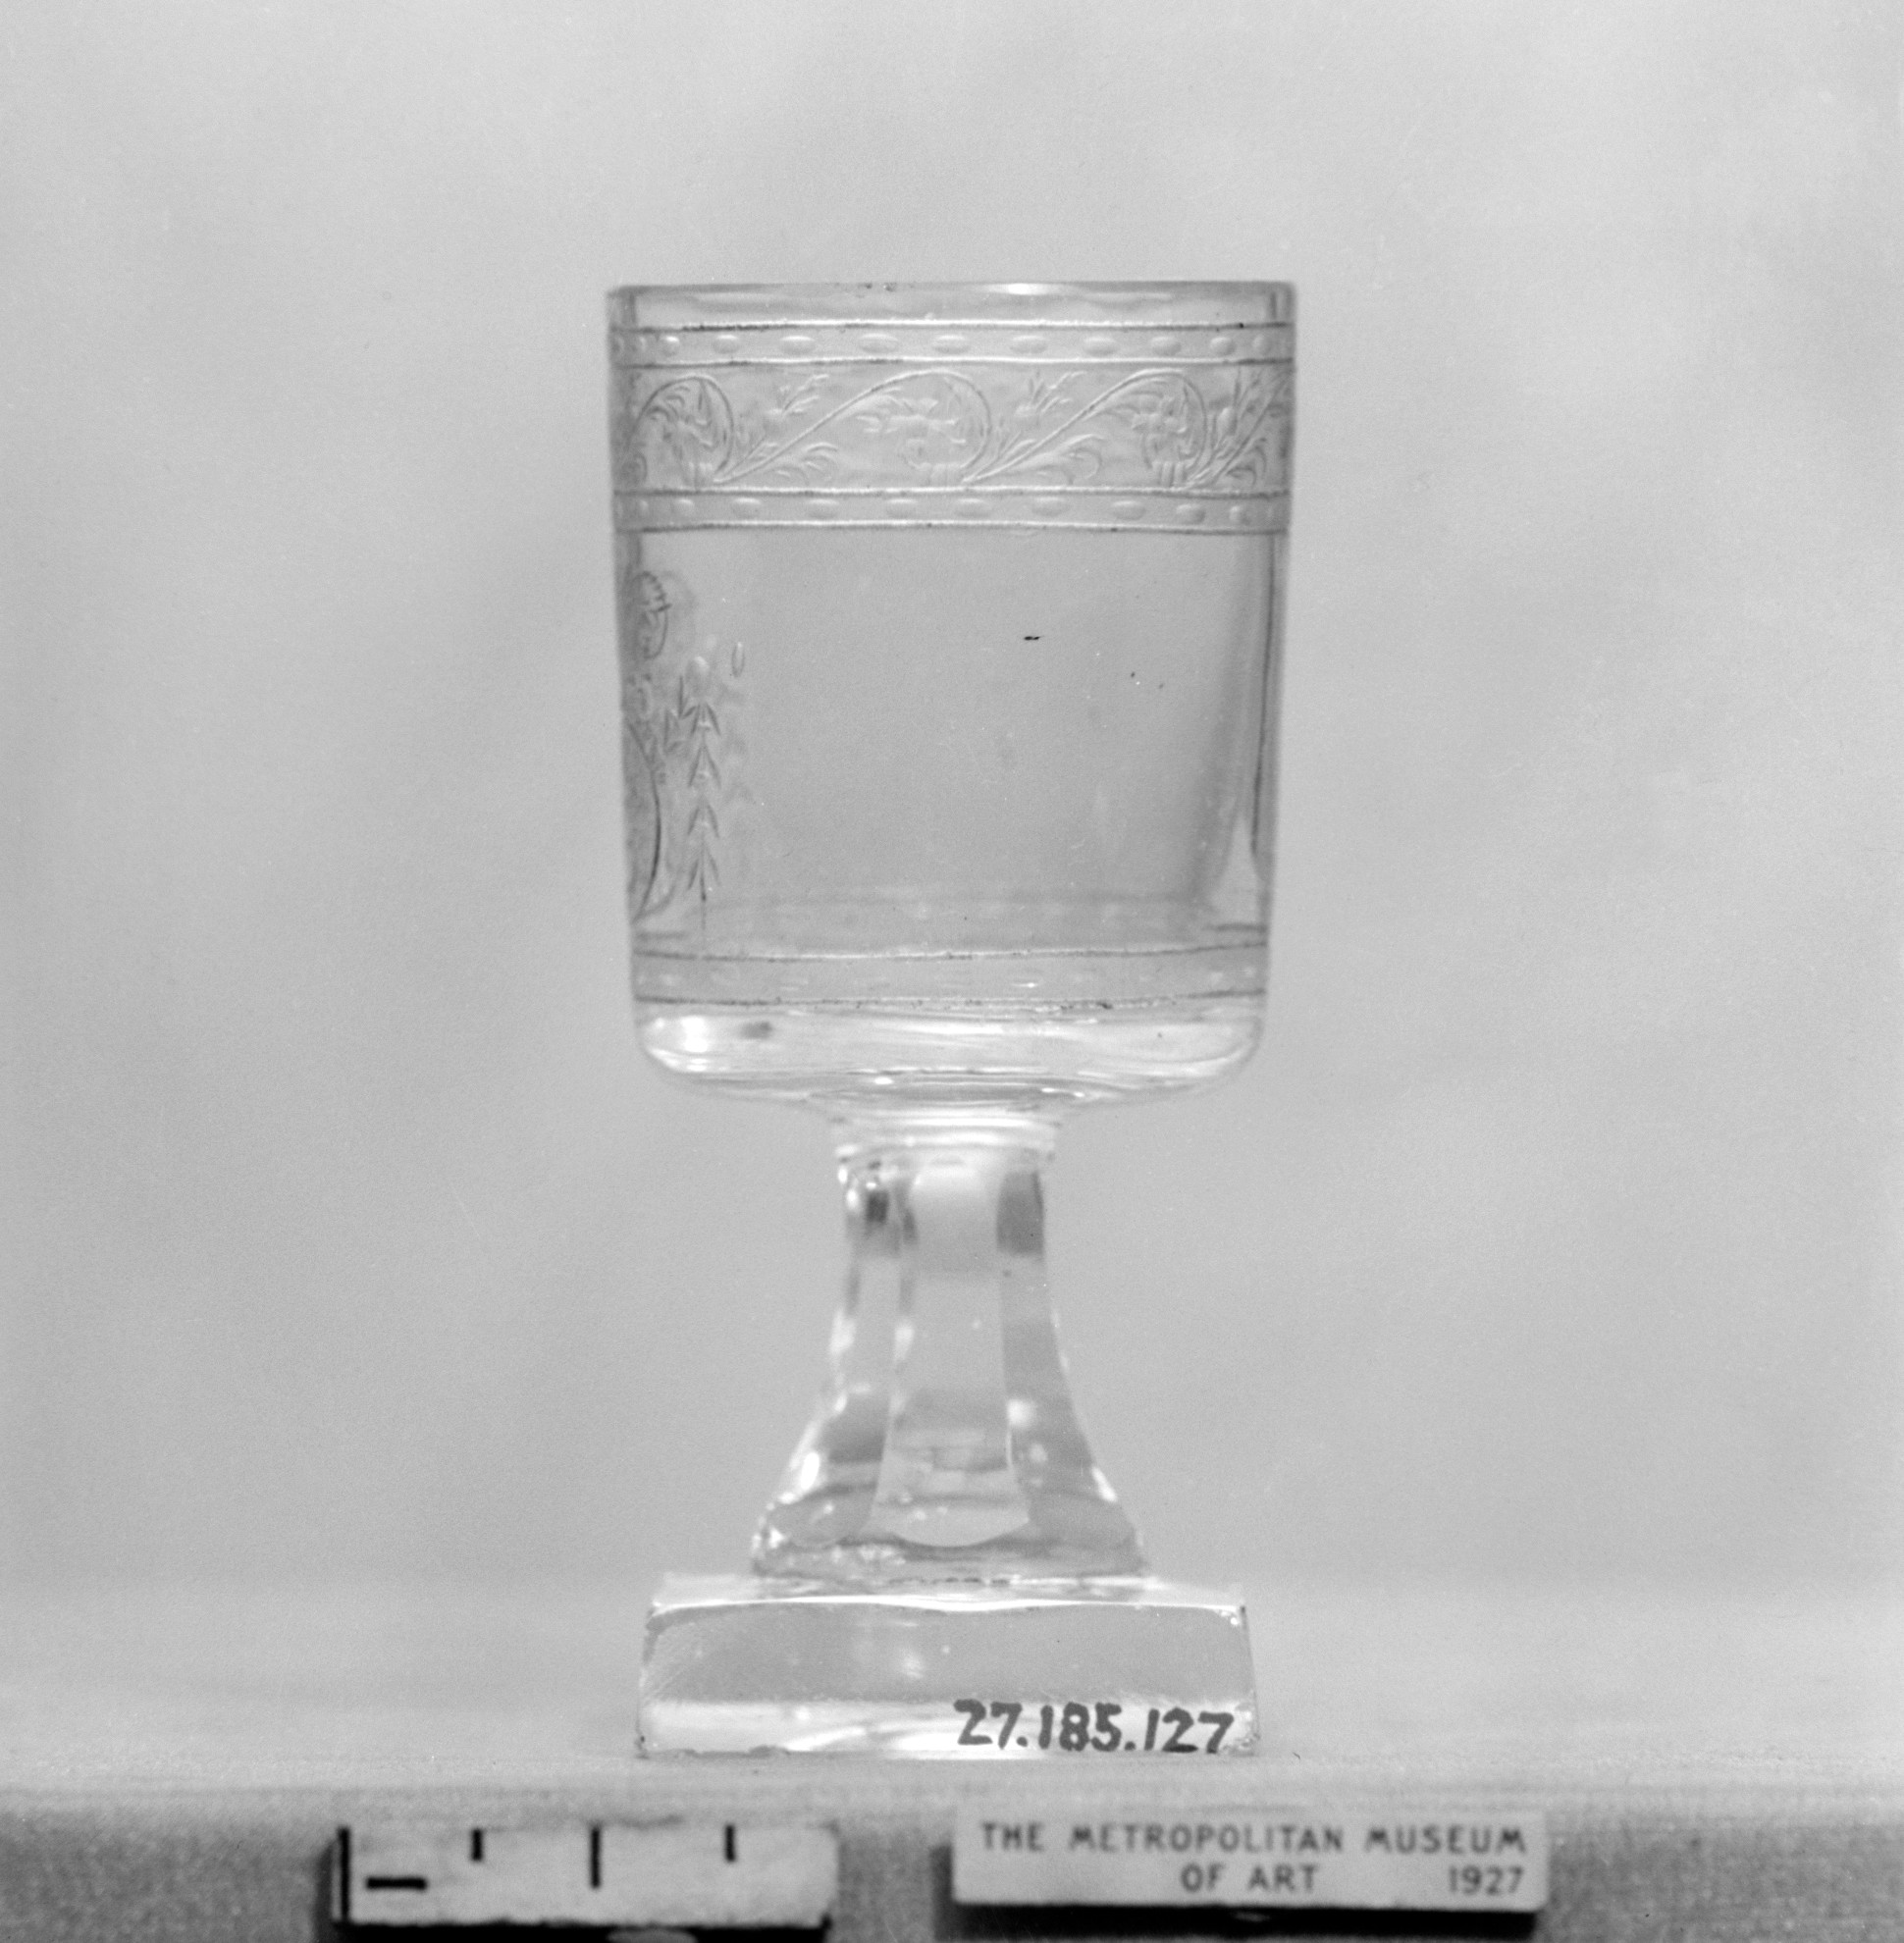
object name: vodka or liqueur glass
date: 1800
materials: glass